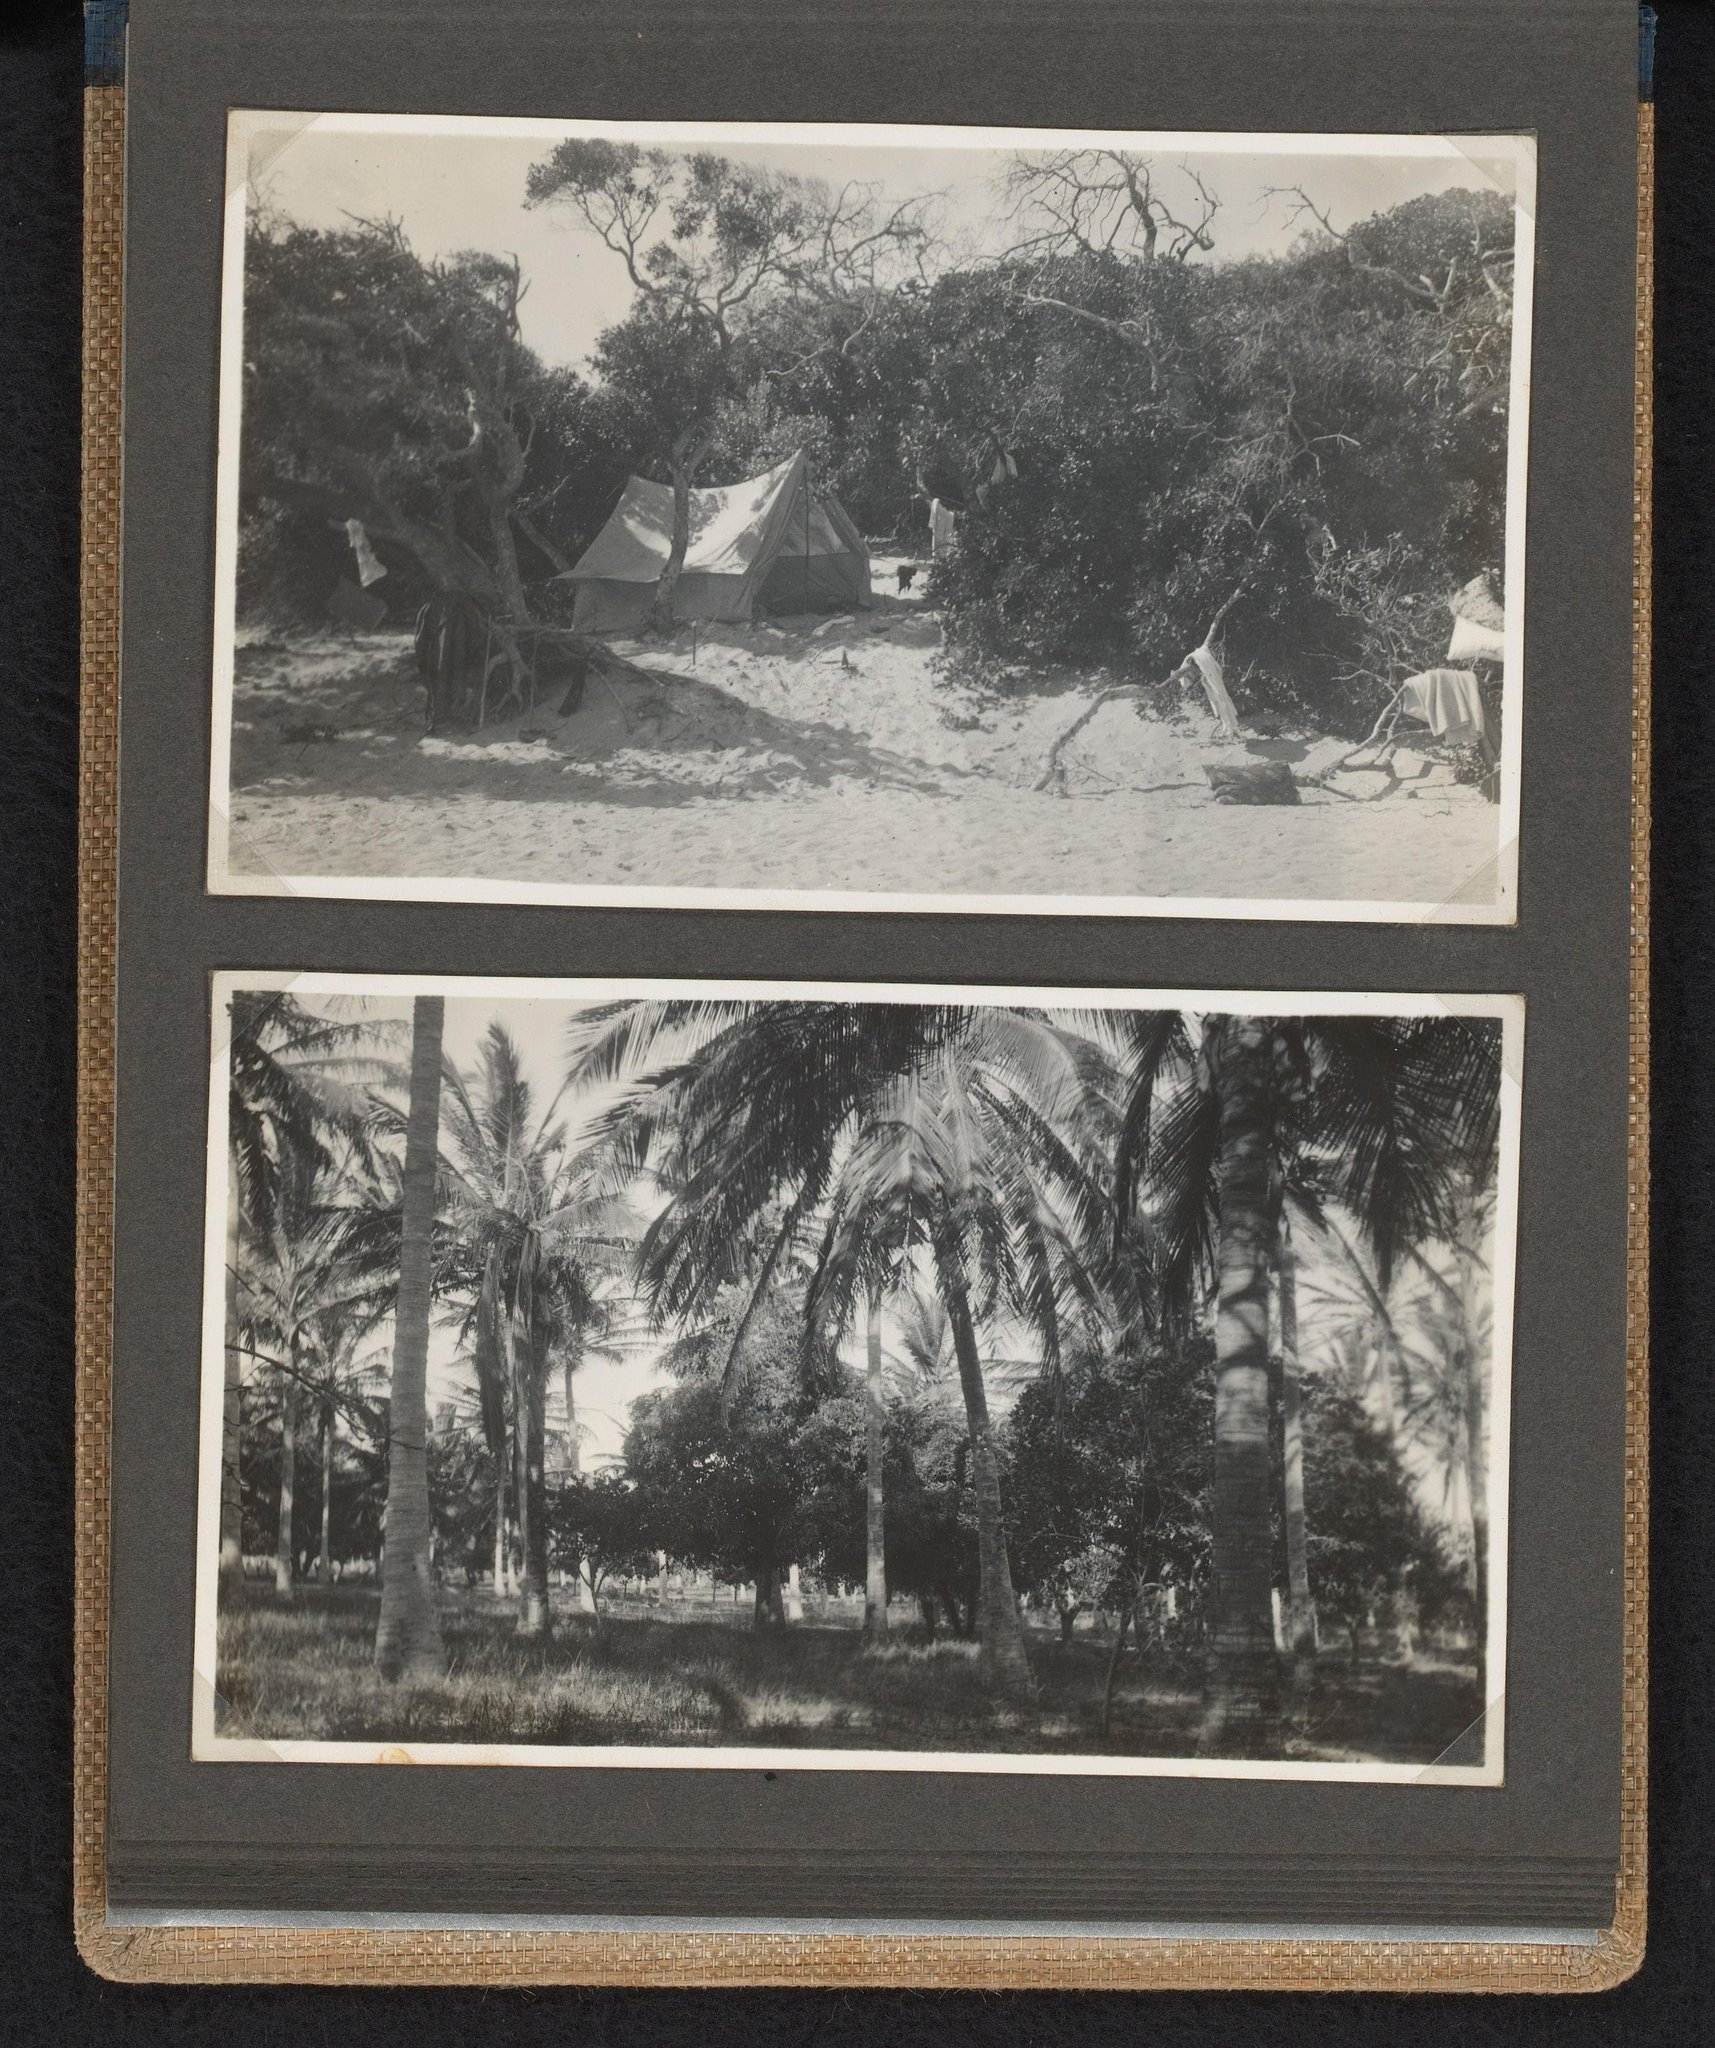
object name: album leaf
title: Tent in een bosgebied, in Zuid-Afrika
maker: karel frederik van den berg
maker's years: 1873-1948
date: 1920-1930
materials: paper, cardboard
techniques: gelatin silver print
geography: south africa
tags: tent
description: Deze foto's zijn onderdeel van een album.